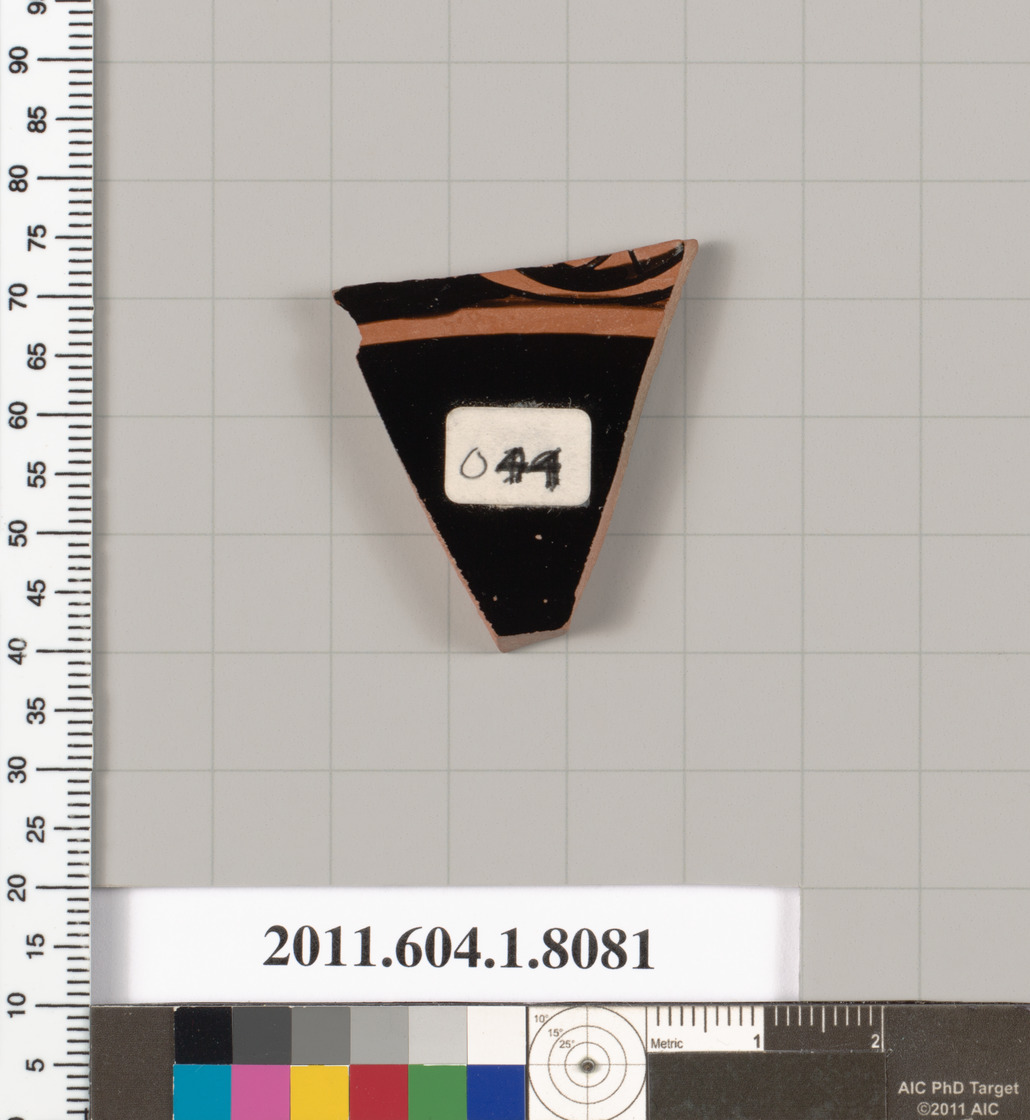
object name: kylix fragment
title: Terracotta fragment of a kylix (drinking cup)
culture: greek, attic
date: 510-500 BCE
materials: terracotta